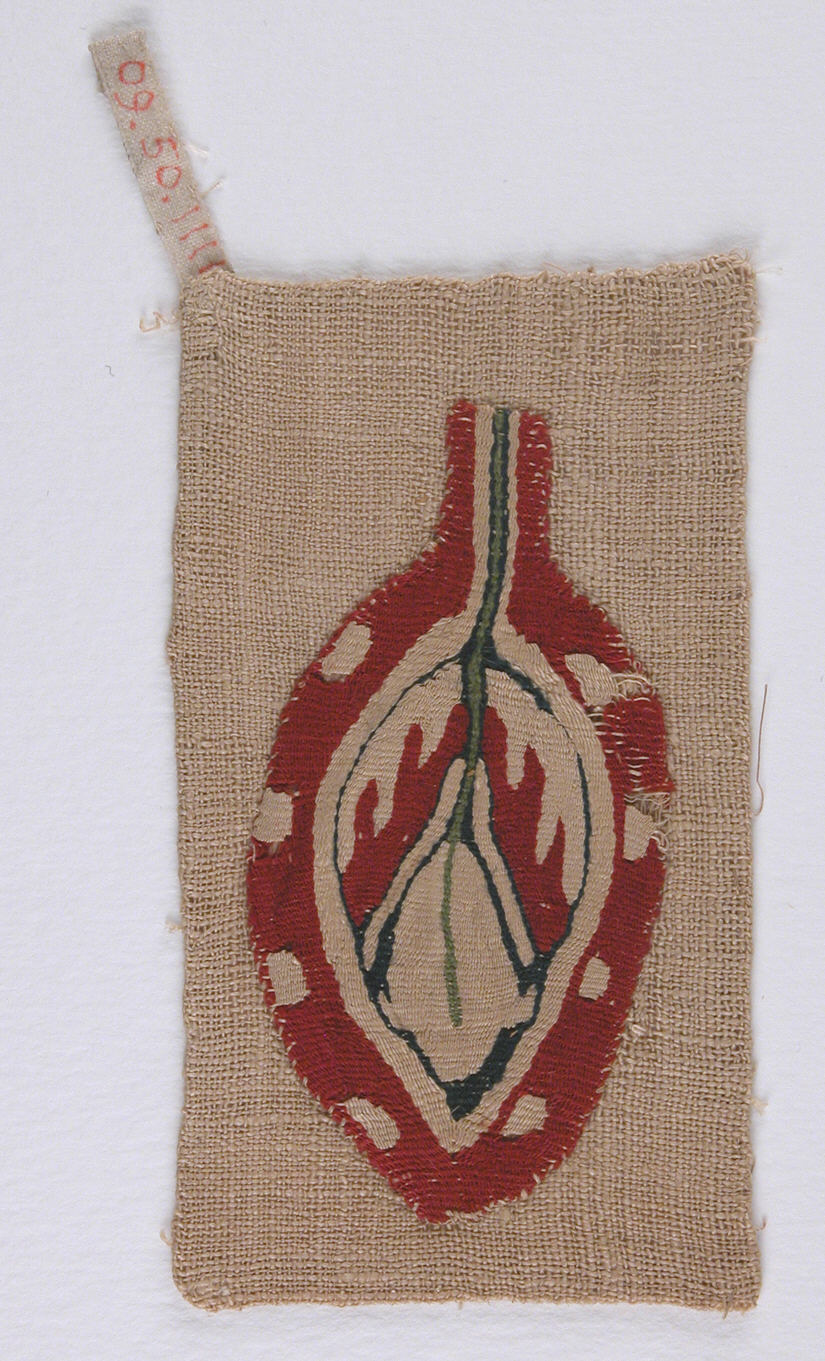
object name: ornament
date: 401-600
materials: linen, wool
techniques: weave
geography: egypt